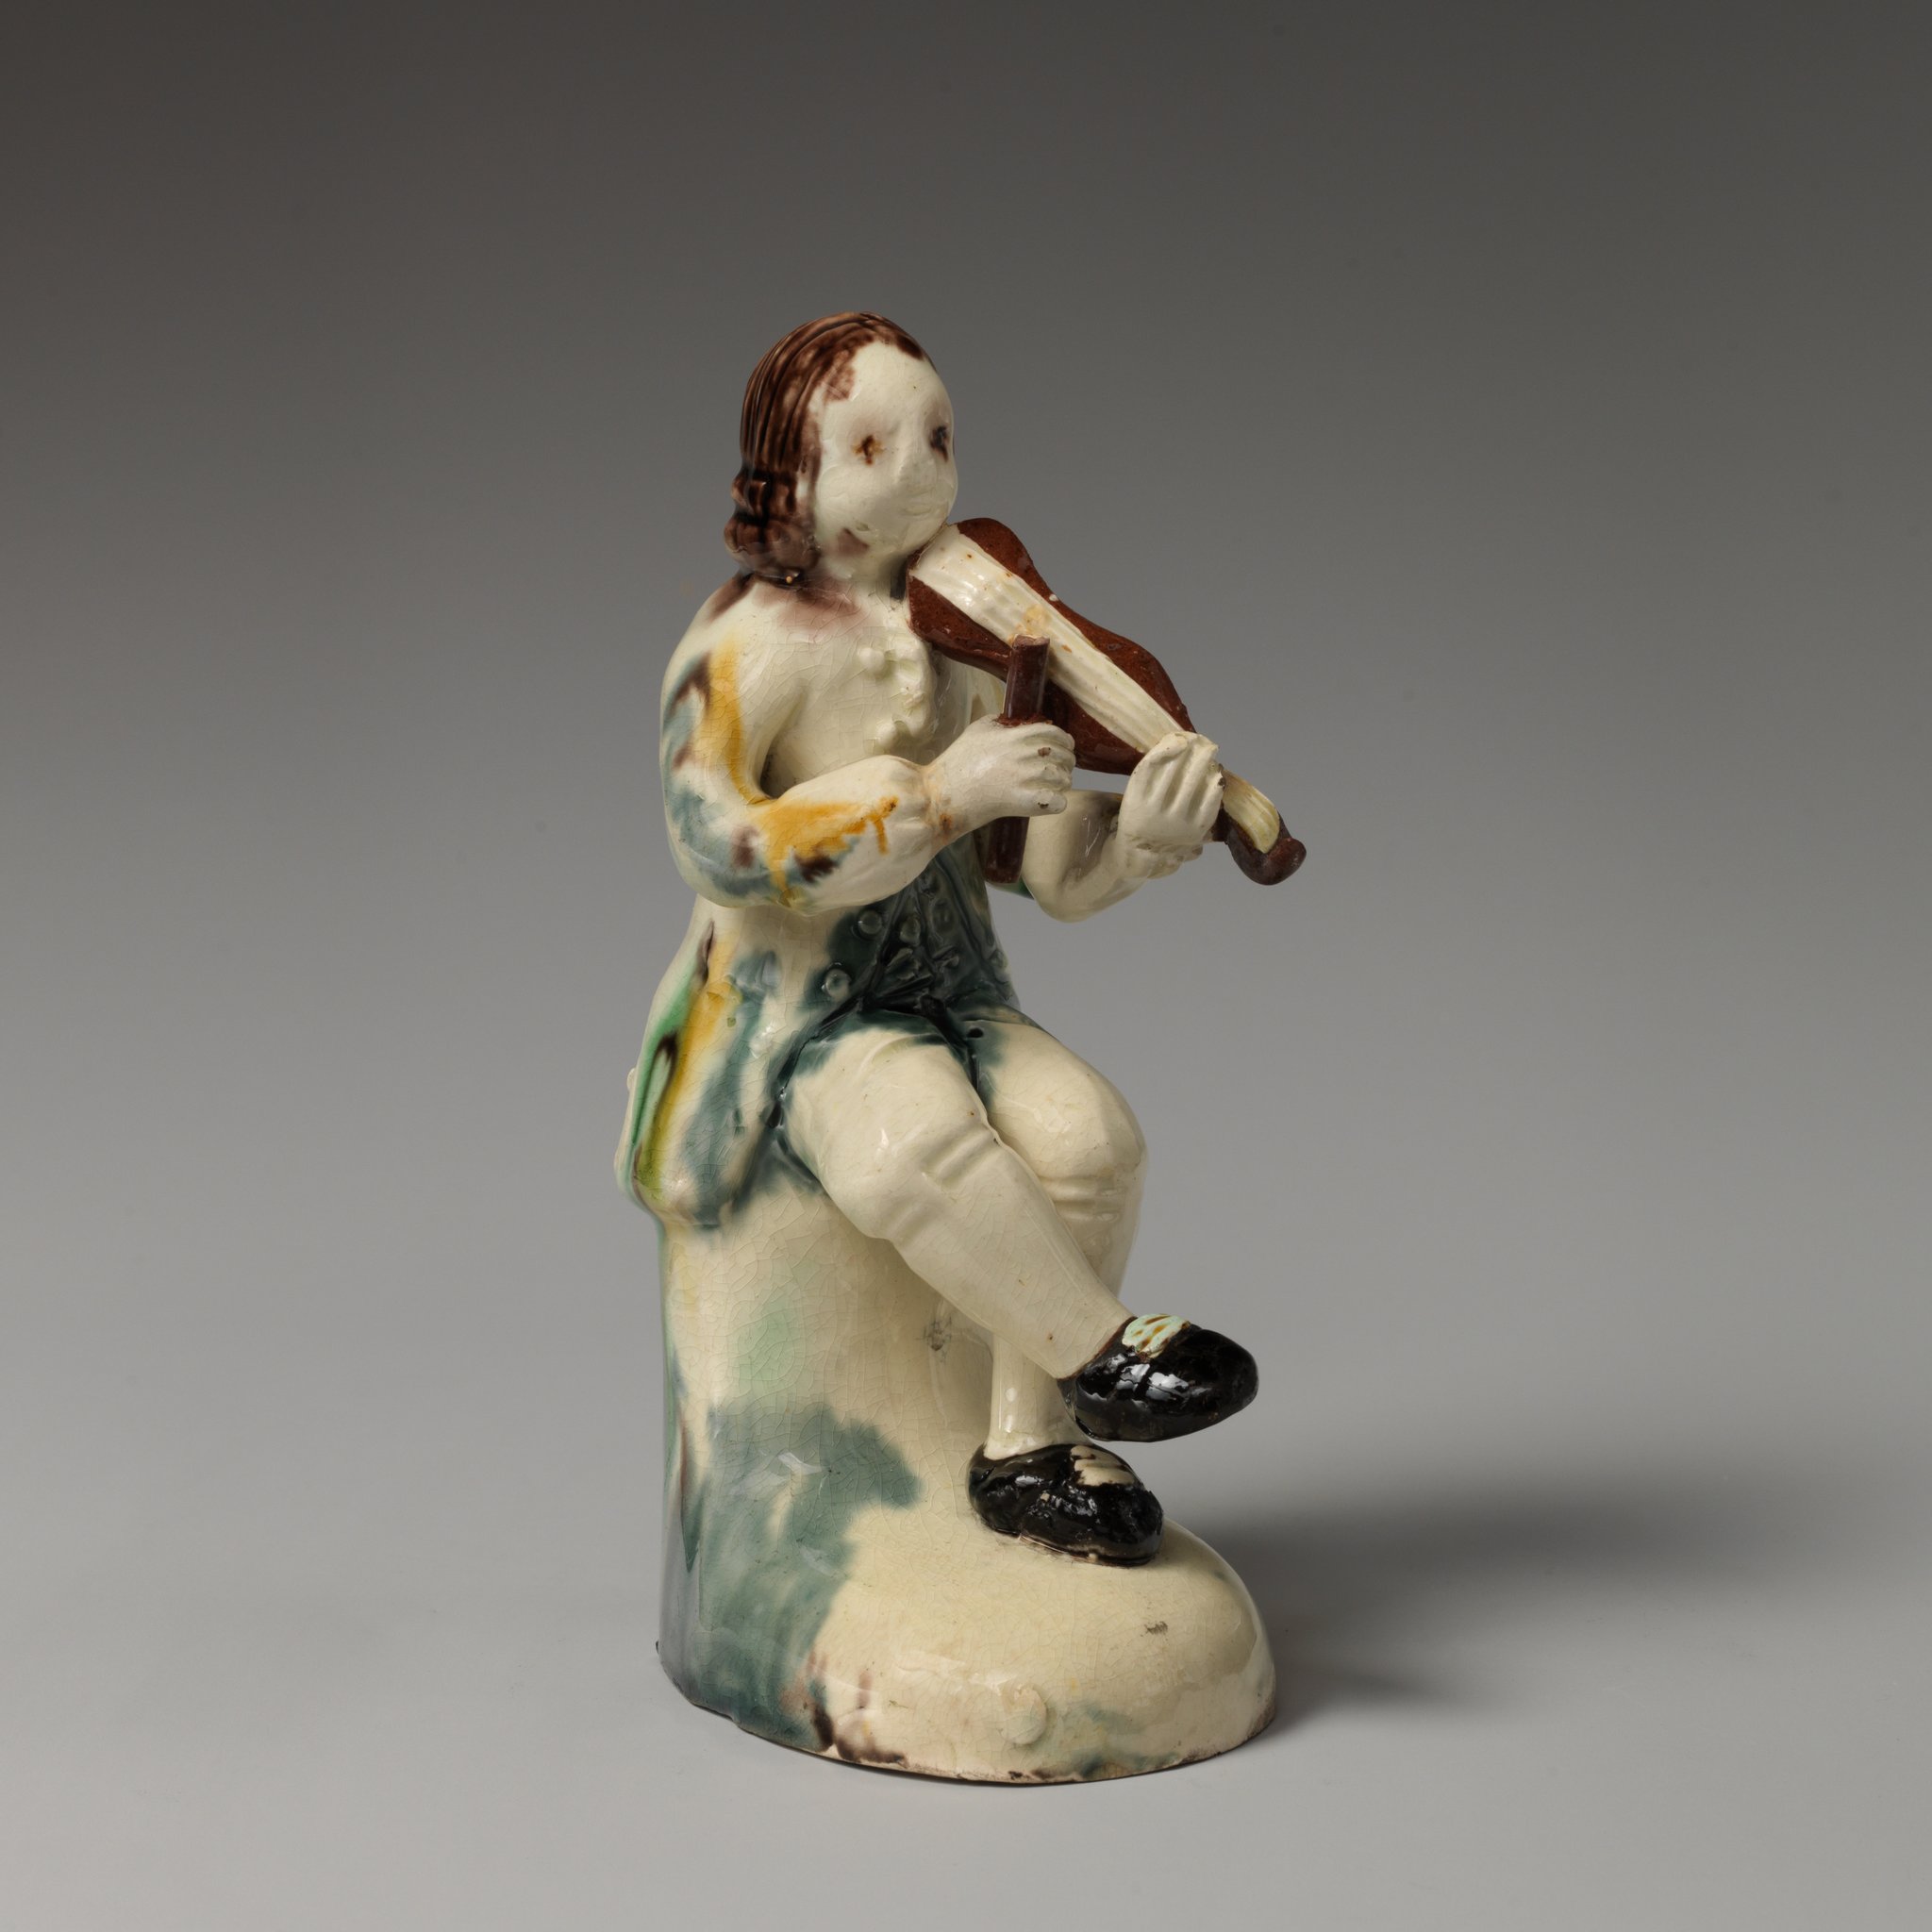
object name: figure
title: Fiddler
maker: astbury-whieldon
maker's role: maker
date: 1745-1750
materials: earthenware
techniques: glazing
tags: men,violins